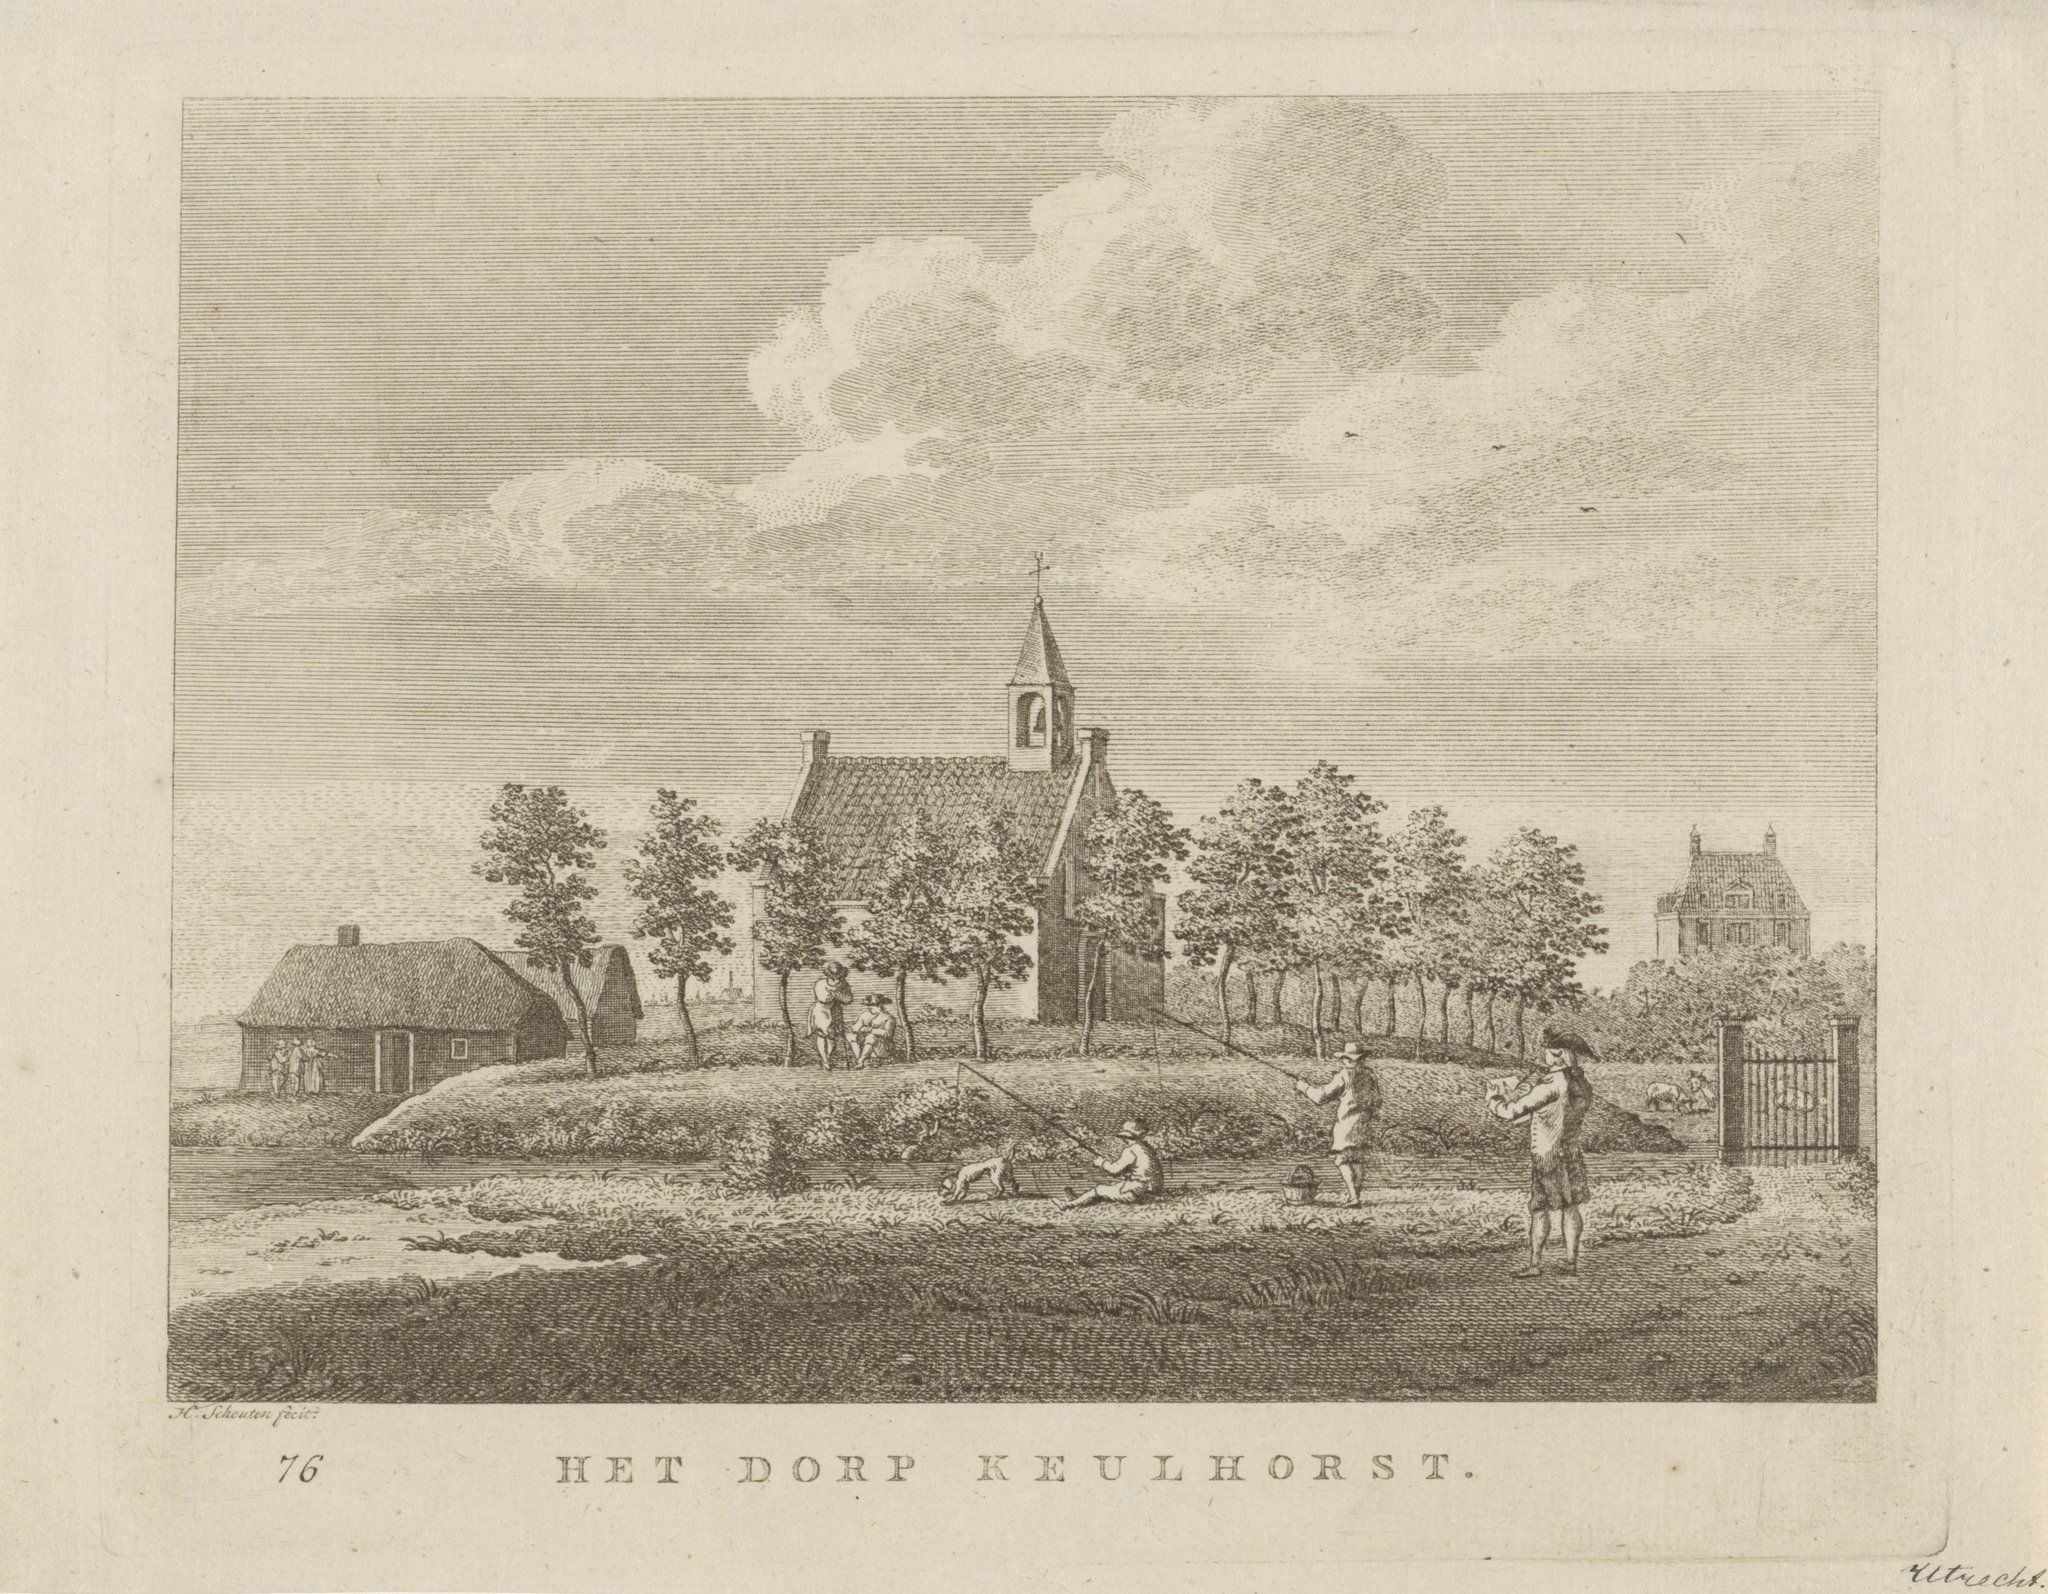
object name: print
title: Gezicht op Keulhorst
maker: hermanus petrus schouten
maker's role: draughtsman, painter, print maker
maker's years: 1747-1822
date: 1762-1822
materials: paper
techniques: etching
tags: inspiration of the artist (in general) - bb - out of doors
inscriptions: collector's mark: Lugt 2228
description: Gezicht op het kerkje van Keulhorst, een buurtschap ten noordwesten van Amersfoort. Op de voorgrond een tekenaar die de kerk en de vissers voor hem in een schetsboek vastlegt. Links een boerderij, rechts een landhuis. Linksonder genummerd "76".